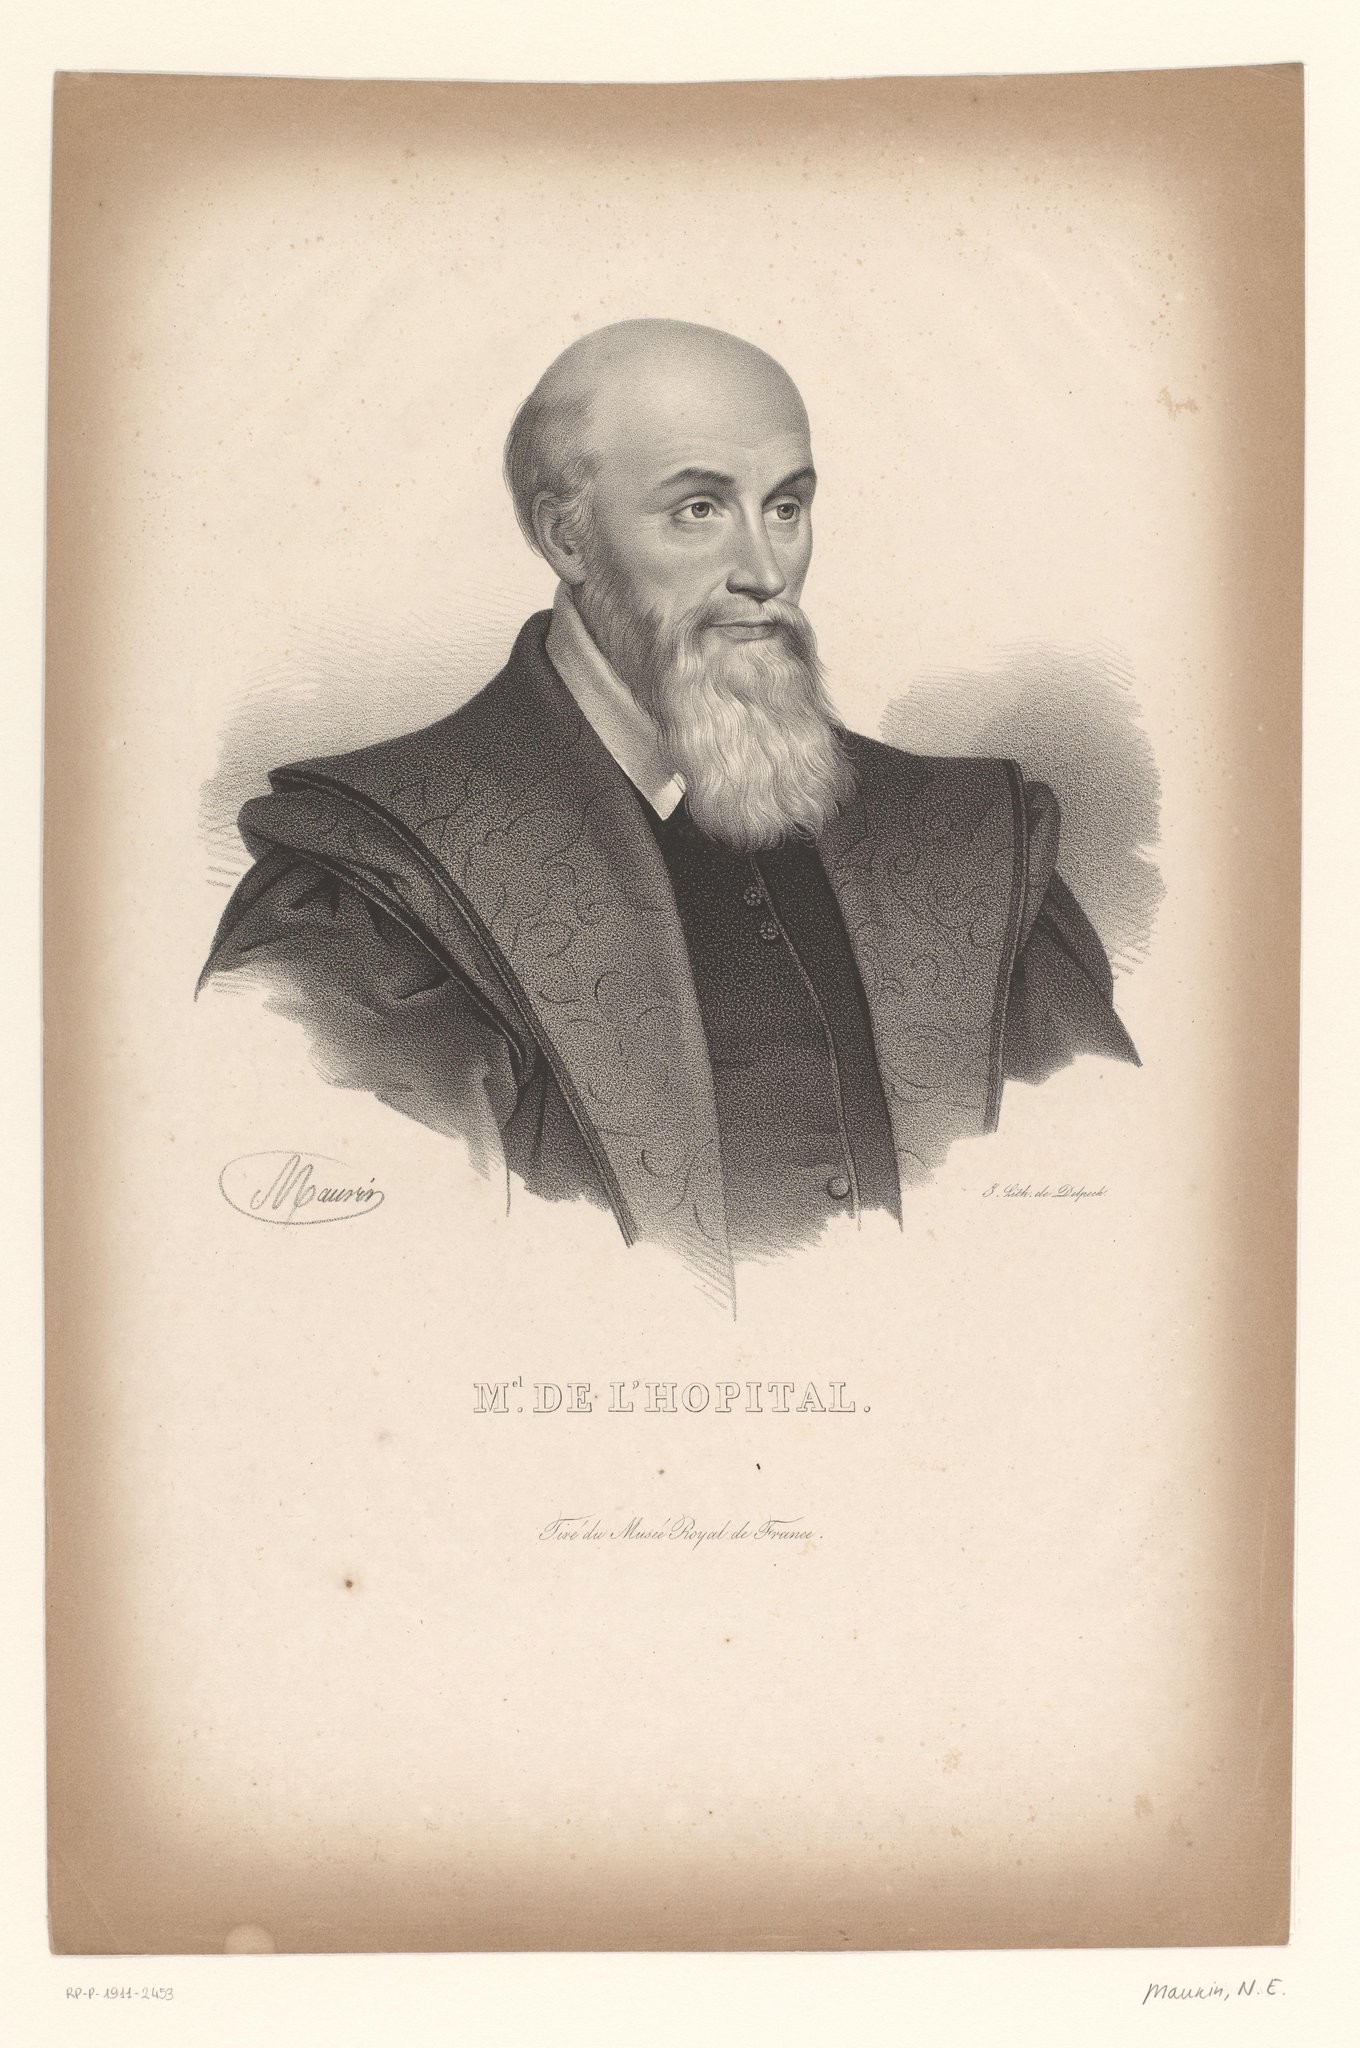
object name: print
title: Mel. de l'Hopital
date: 1825-1842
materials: paper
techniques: lithograph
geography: paris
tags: historical persons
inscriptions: collector's mark: Lugt 2228